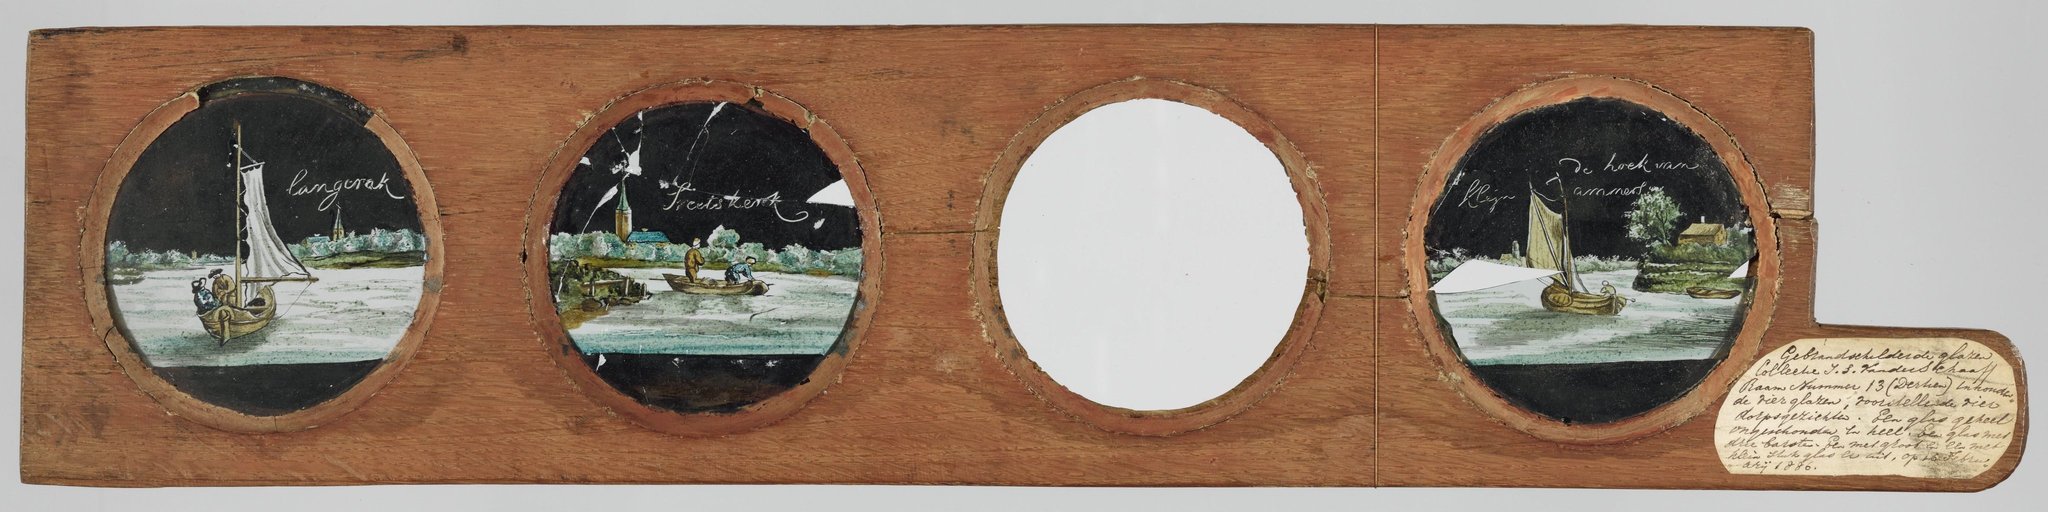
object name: lantern slide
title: Drie Nederlandse dorpsgezichten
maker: Anonymous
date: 1700-1790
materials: glass, wood, oil, paint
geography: netherlands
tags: streefkerk, klein-ammers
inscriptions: label: ‘'Gebrandschilderde glazen. Collectie I.S. van der Schaaff, Baarn. Nummer 13 (dertien) inhoudende drie glazen, voorstellende drie dorpsgezichten. Eén glas geheel ongeschonden en heel. Eén glas met een barst en één glas met een klein stuk glas eruit op 16 februarij 1886.'’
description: Drie glazen in houten vatting met handvat. Een vierde glas (het tweede van rechts) ontbreekt. Uiterst links: zeilbootje op water met op achtergrond een dorp, waarboven geschreven 'Langerak.' Rechts daarvan: roeibootje op water met op achtergrond een kerk, daarbij geschreven 'Streefkerk.' Rechts daarvan: glas ontbreekt. Uiterst rechts: een zeilboot op het water, met rechts een klein huisje en links een kerk. Hierboven geschreven: 'de hoek van kleyn ammers.'